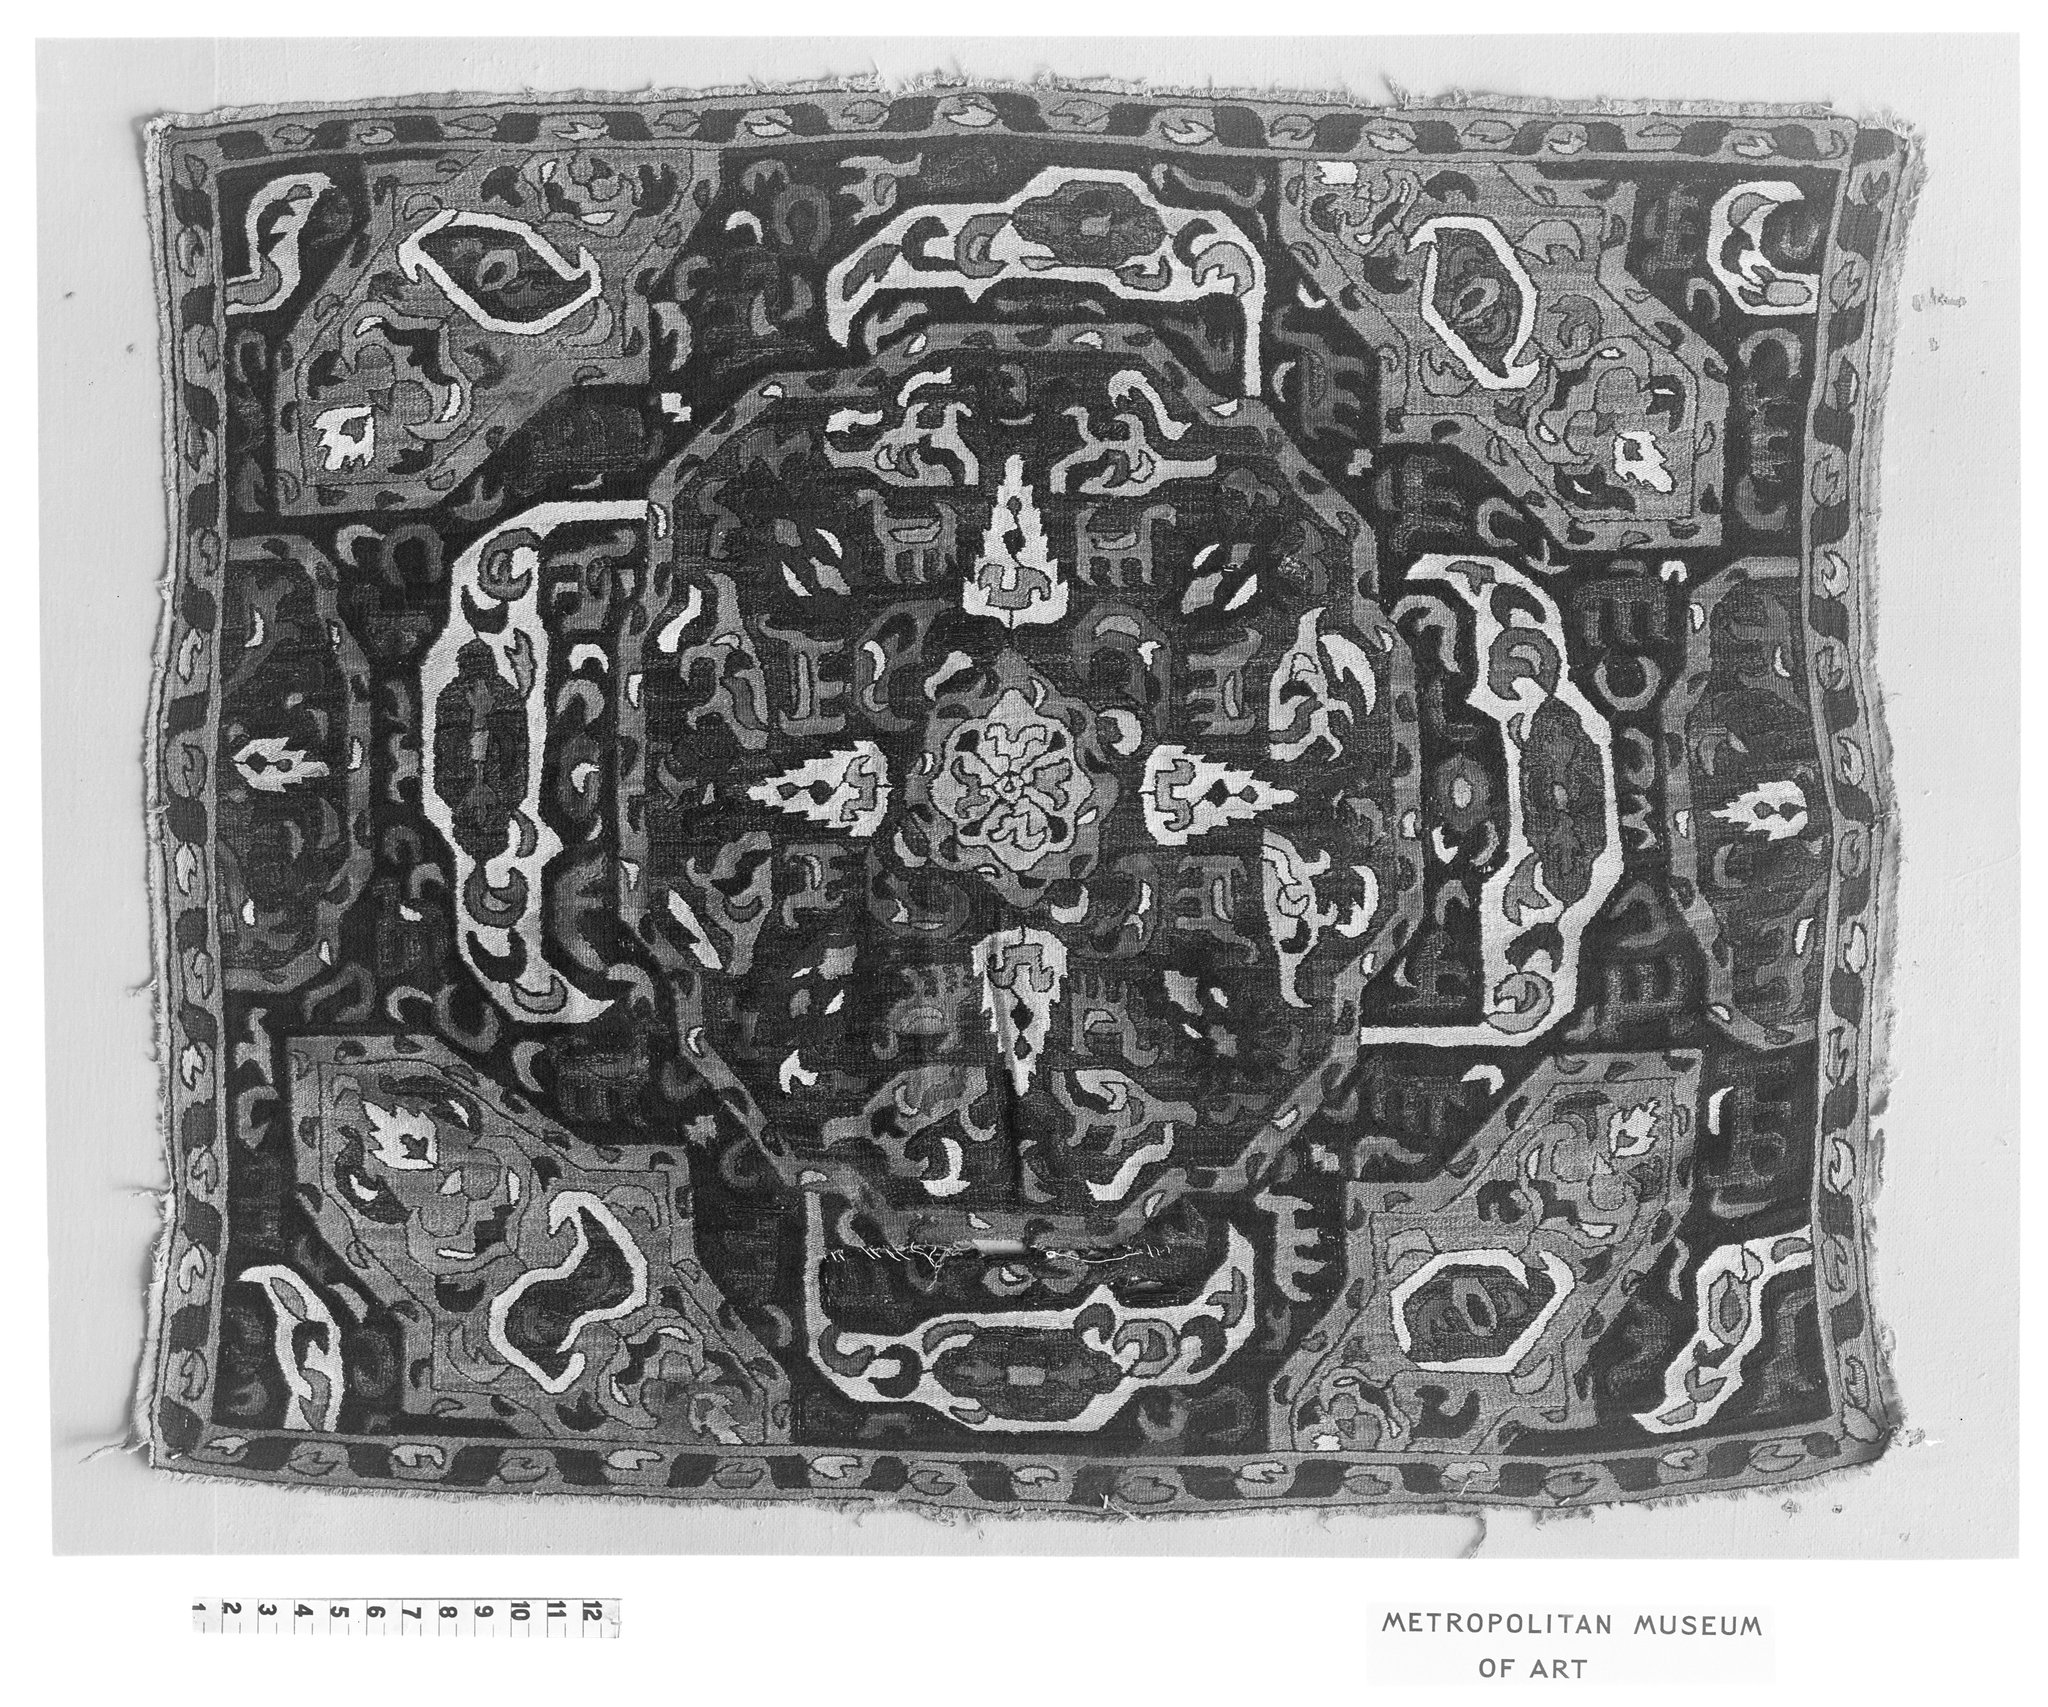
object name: cover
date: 1667-1700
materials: silk, wool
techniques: embroidery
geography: iran